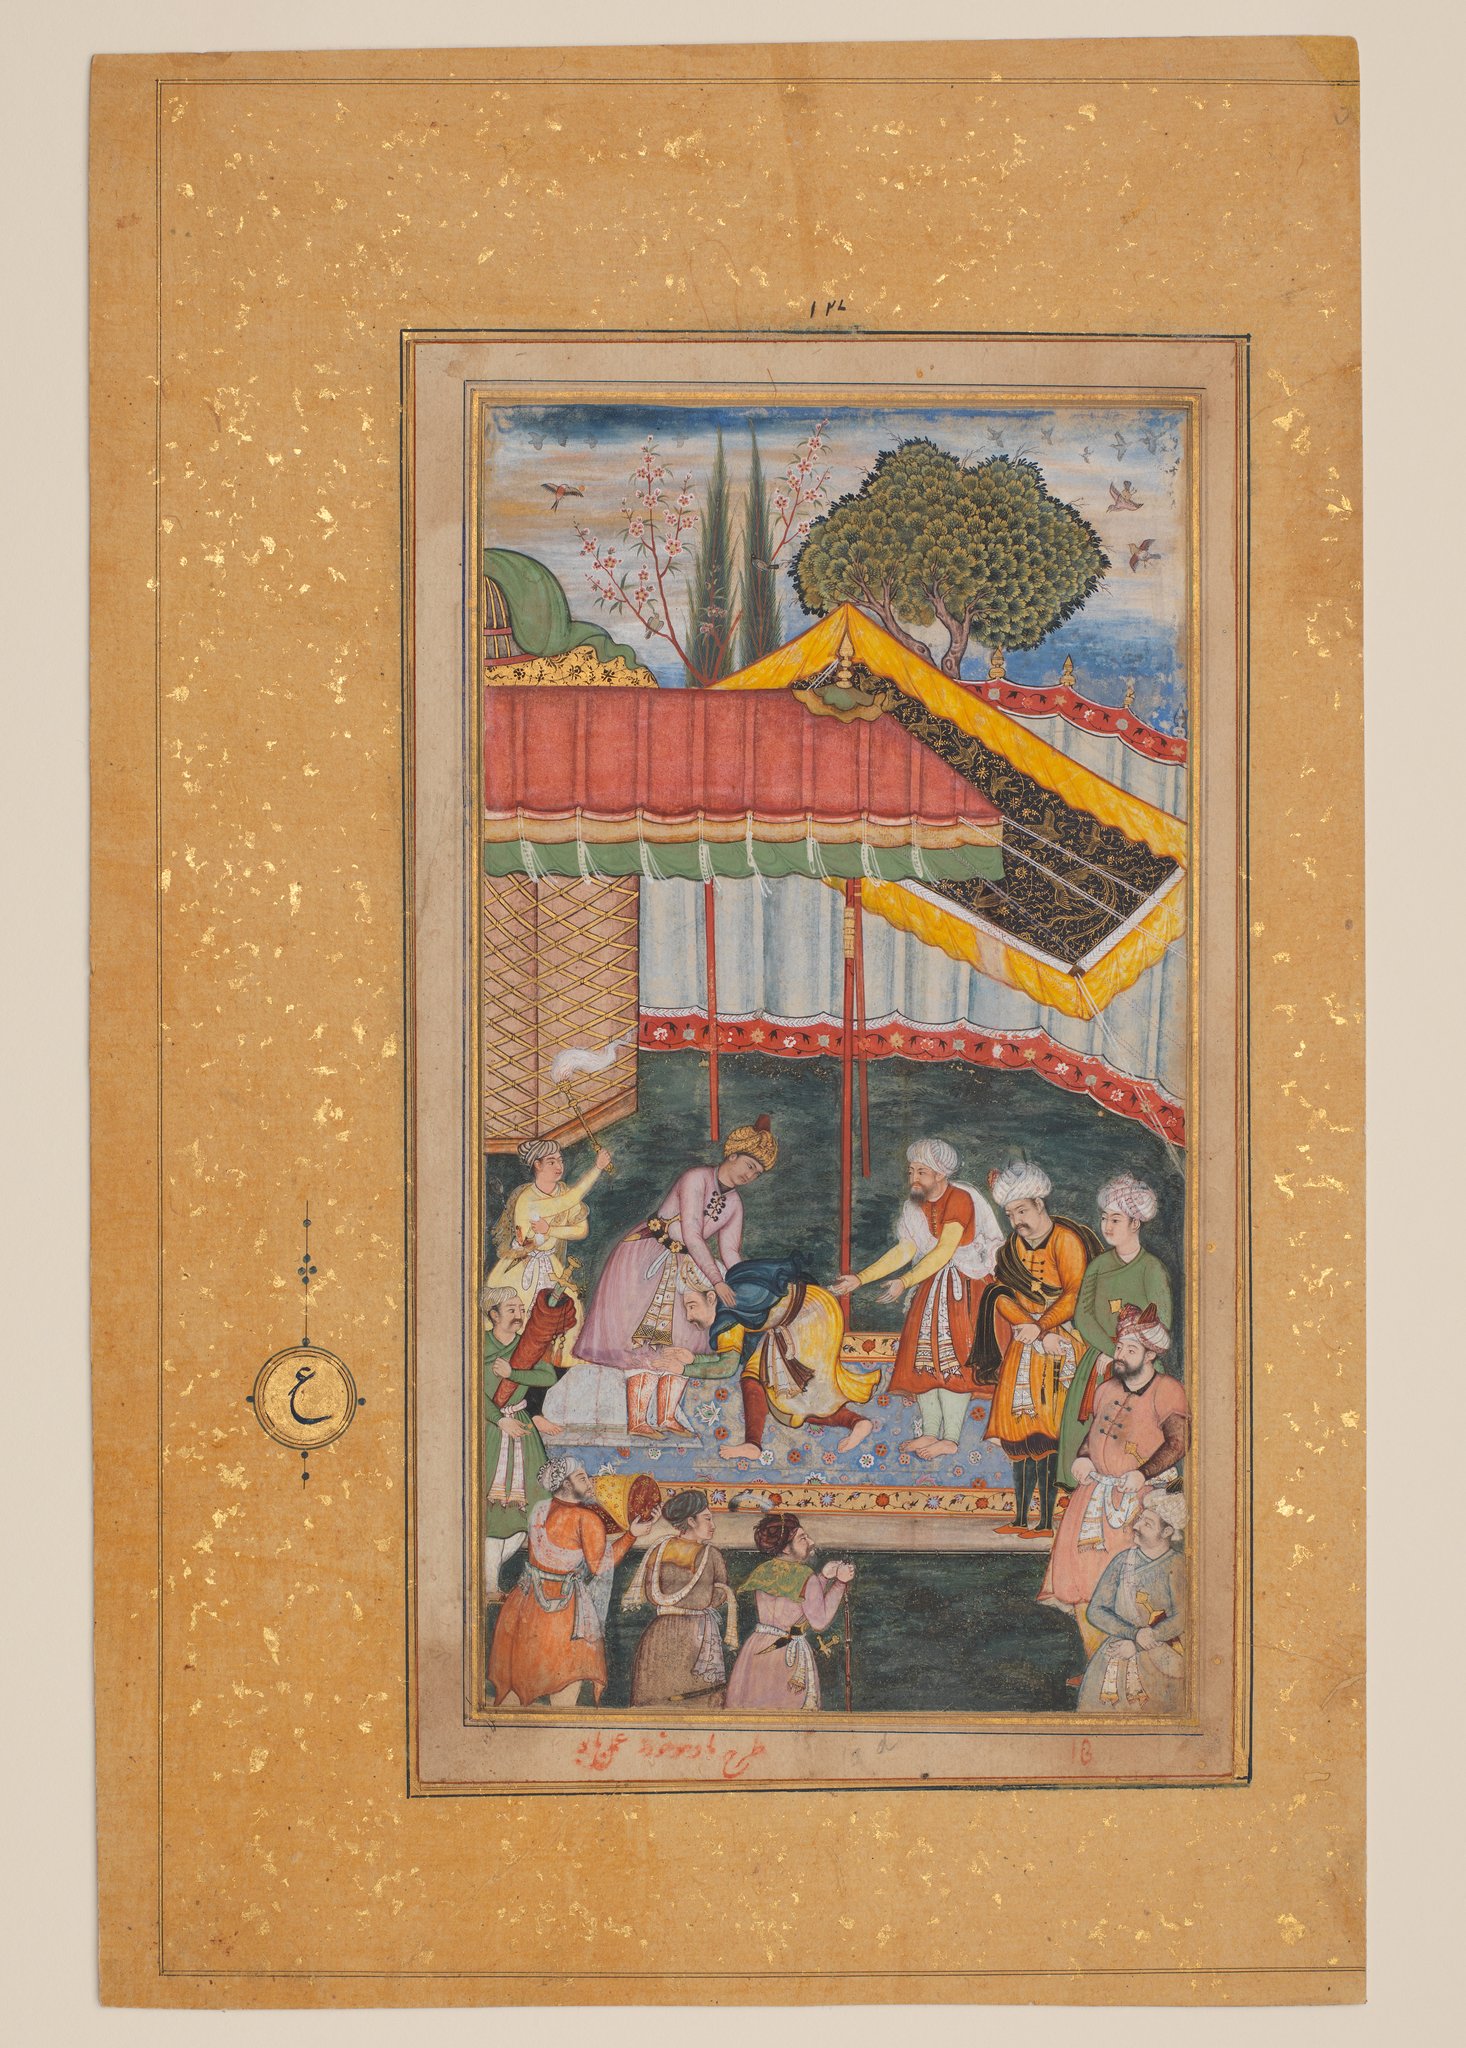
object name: folio from an illustrated manuscript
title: "Emperor Babur Receiving a Visitor", Folio from a Baburnama (The Book of Babur)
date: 1590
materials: gold, ink, paper, watercolor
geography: pakistan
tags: men